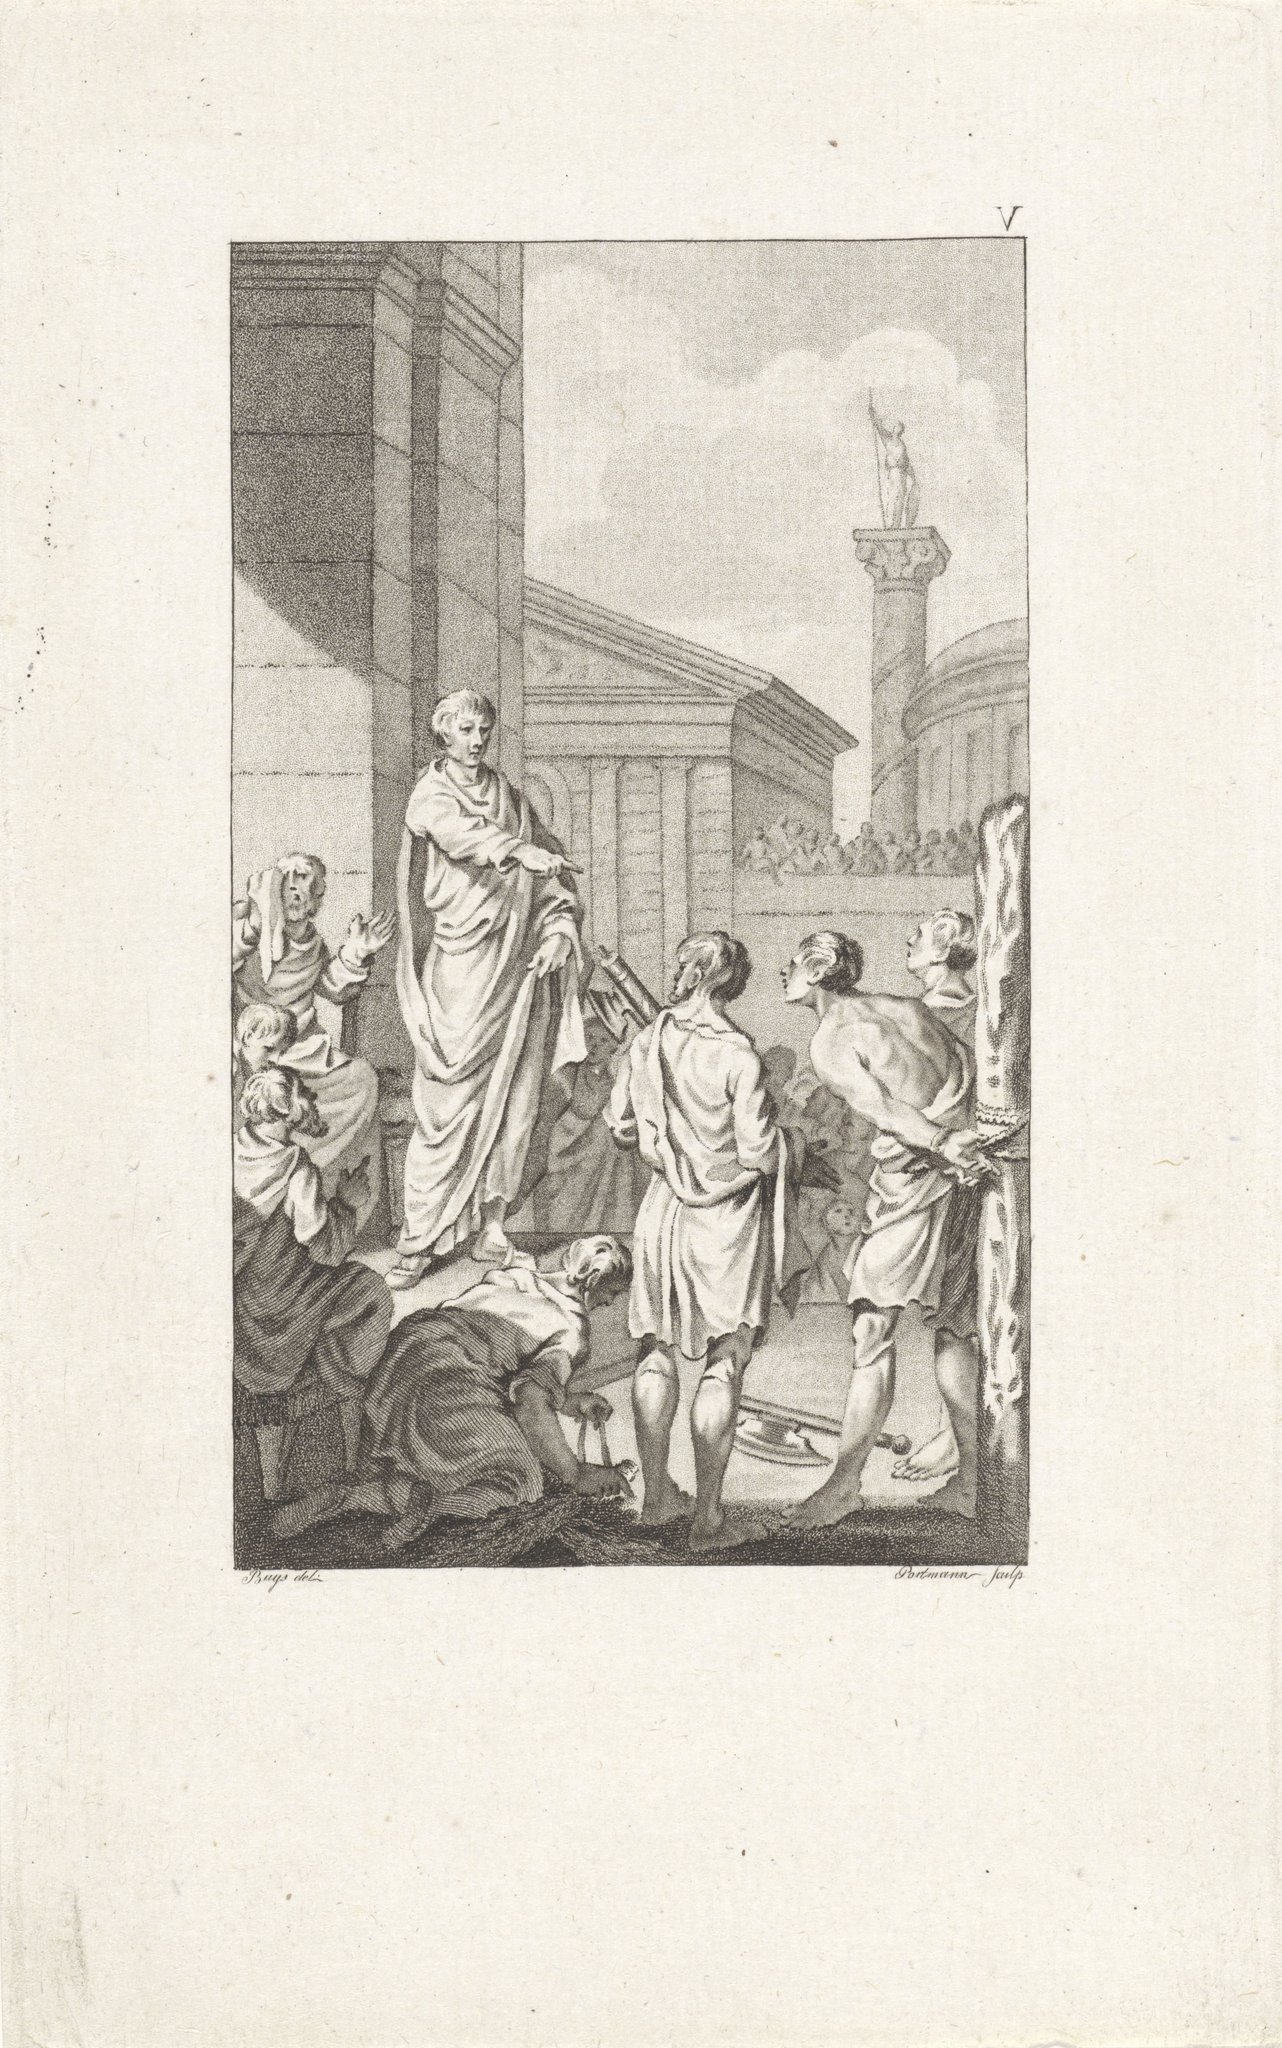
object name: print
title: Lucius Junius Brutus spreekt het vonnis tegen zijn zonen uit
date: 1793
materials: paper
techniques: etching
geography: utrecht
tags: brutus pronounces the verdict condemning his two sons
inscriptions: collector's mark: Lugt 2228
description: Titus en Tiberius, de zonen van de Romeinse consul Lucius Junius Brutus, waren betrokken bij een samenzwering om de monarchie weer aan de macht te helpen. Maar hun plannen werden verijdeld en zij werden gevangen gezet. Ze worden door hun vader ter dood veroordeeld.